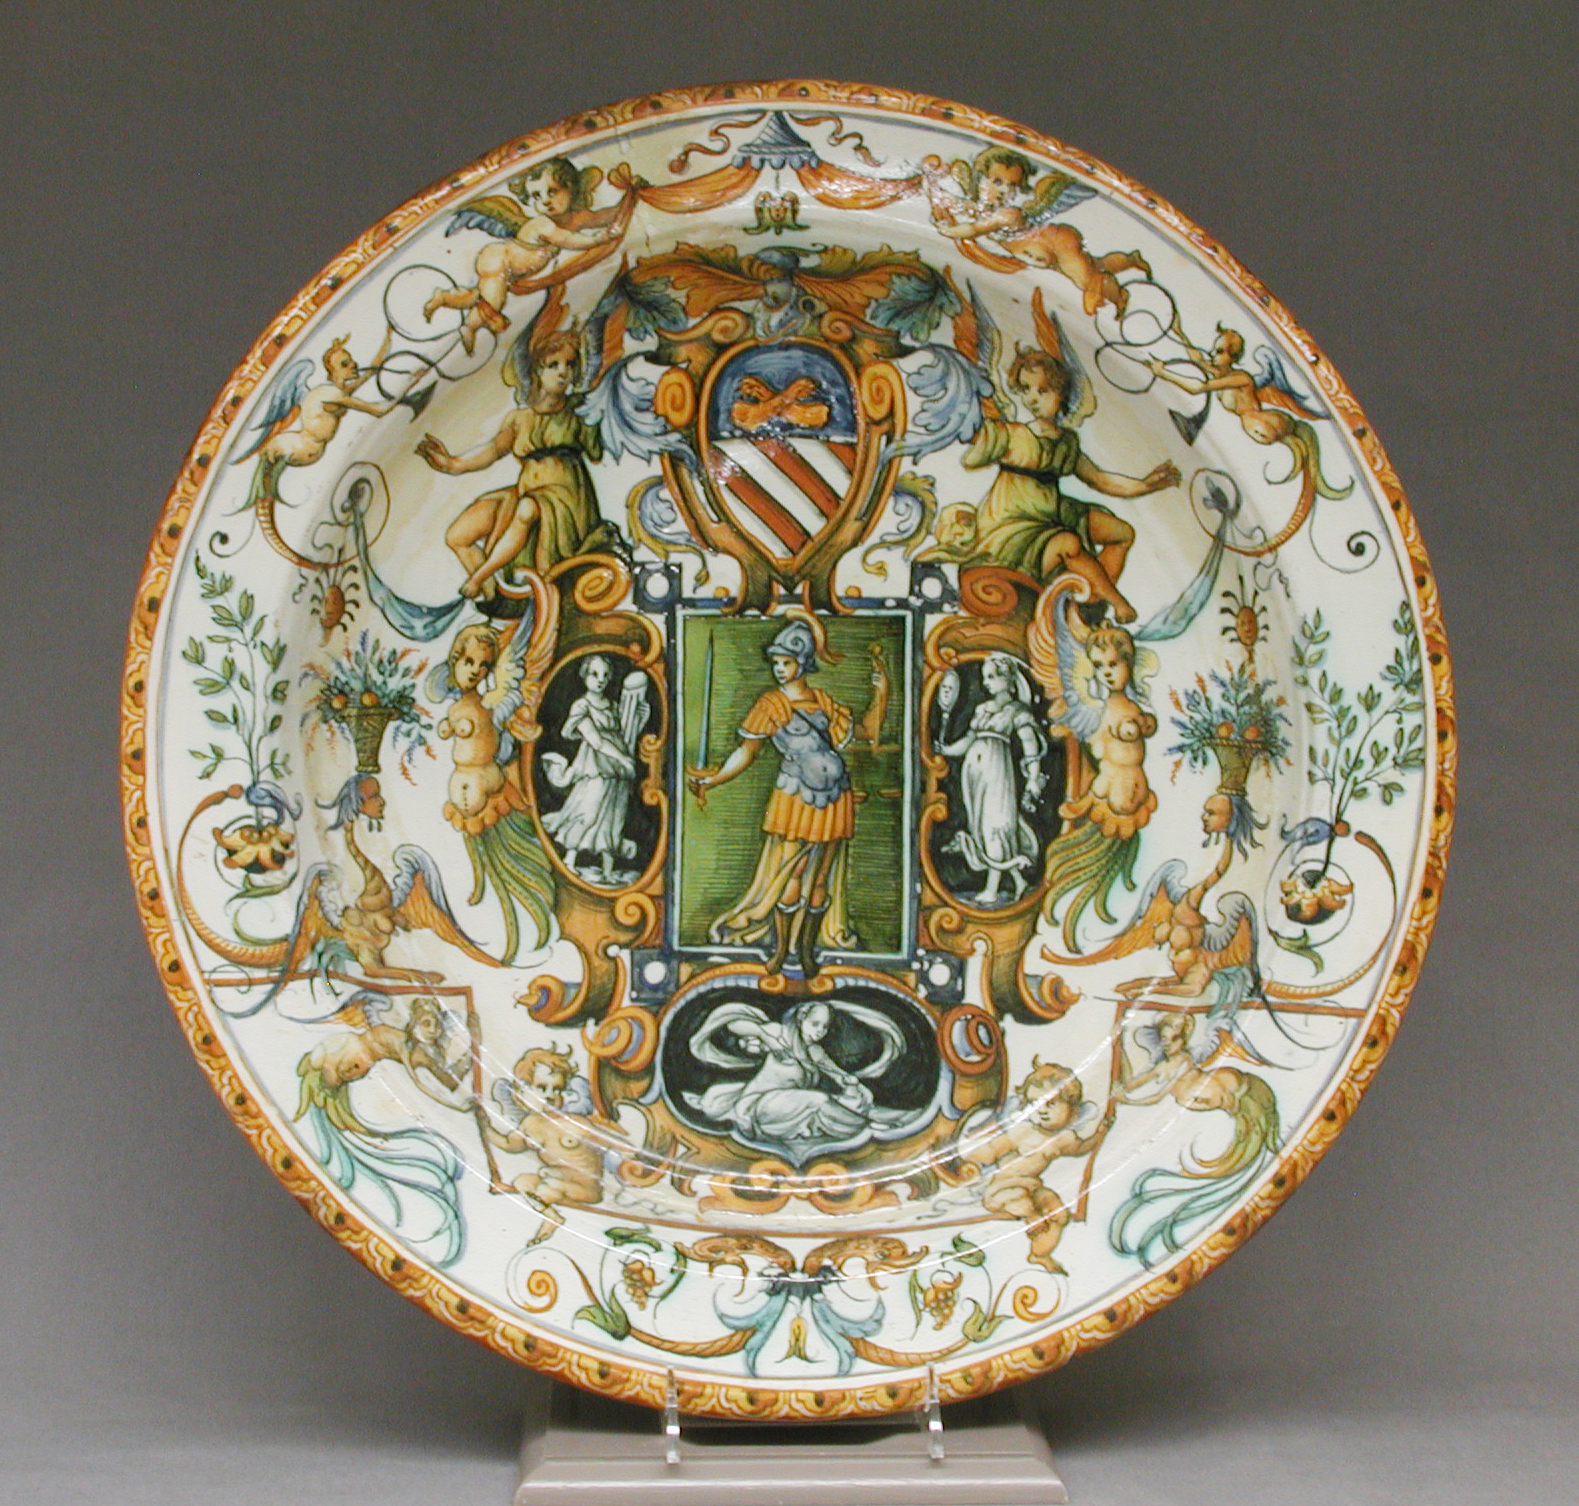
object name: plate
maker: patanazzi family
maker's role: maker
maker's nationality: italian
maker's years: 1575-1625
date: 1600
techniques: maiolica, glazing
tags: coat of arms